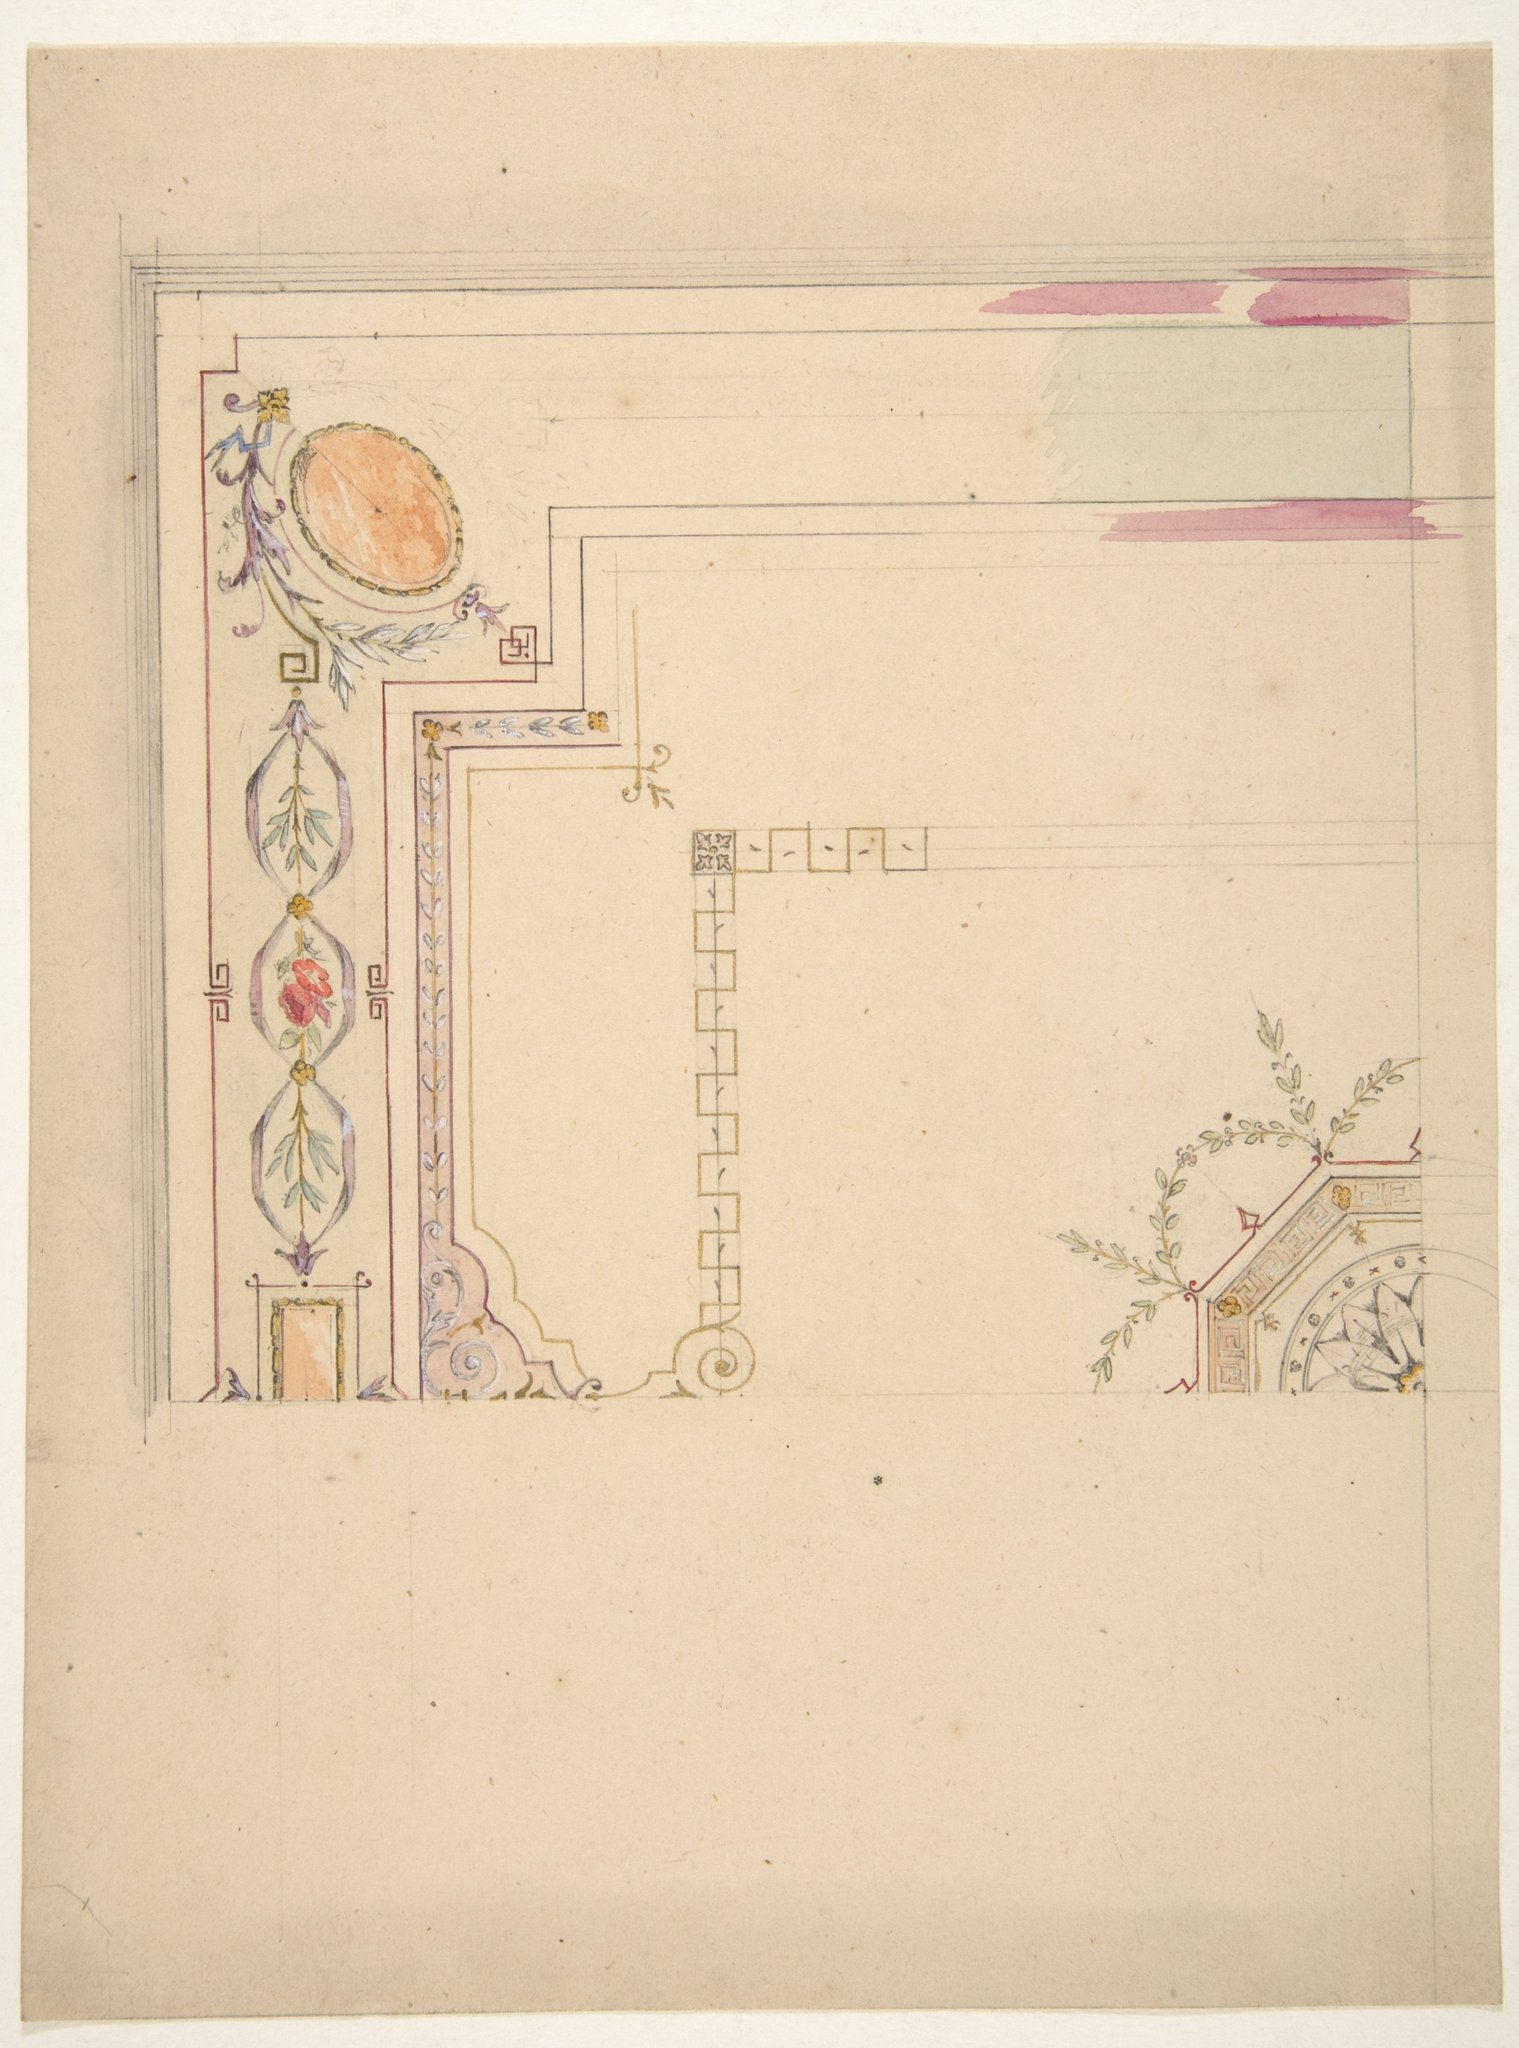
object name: drawing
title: Design for a Ceiling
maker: jules-edmond-charles lachaise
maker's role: artist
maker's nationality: french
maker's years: 1897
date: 1851-1900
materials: gilt, gouache, graphite, watercolor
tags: architecture